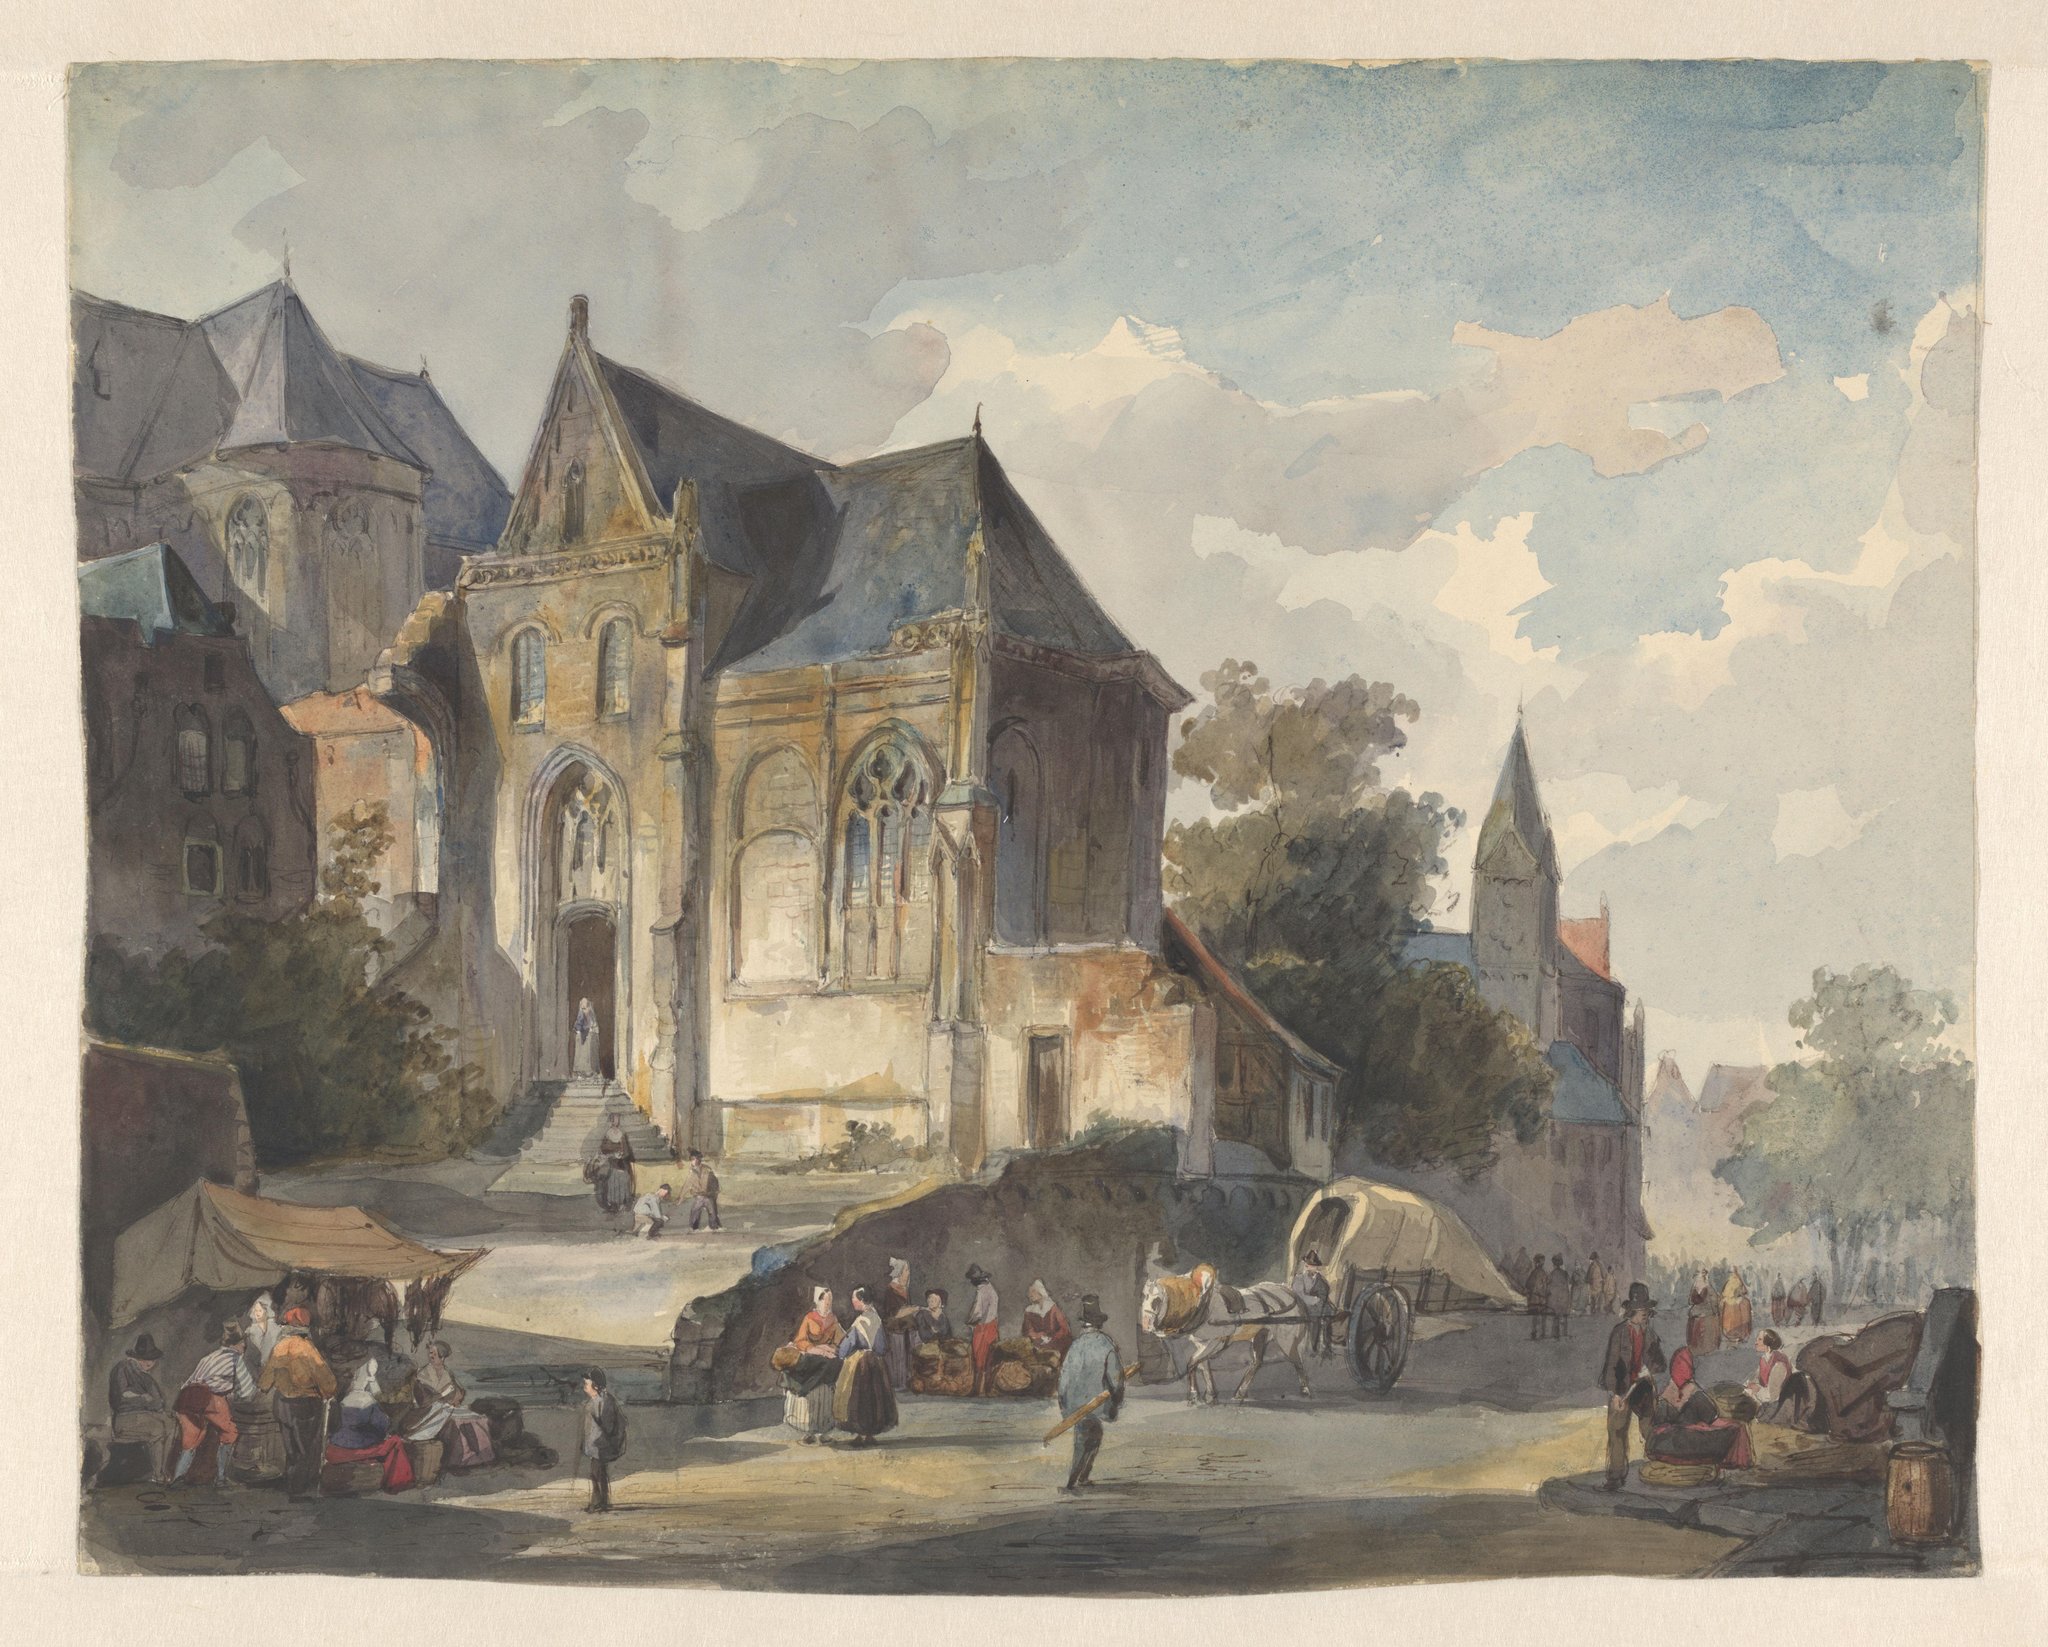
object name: drawing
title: Stadsgezicht met kerkgebouw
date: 1840-1860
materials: chalk, ink, paper, pencil, watercolor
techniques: brush, pen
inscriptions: number: ‘00:500’